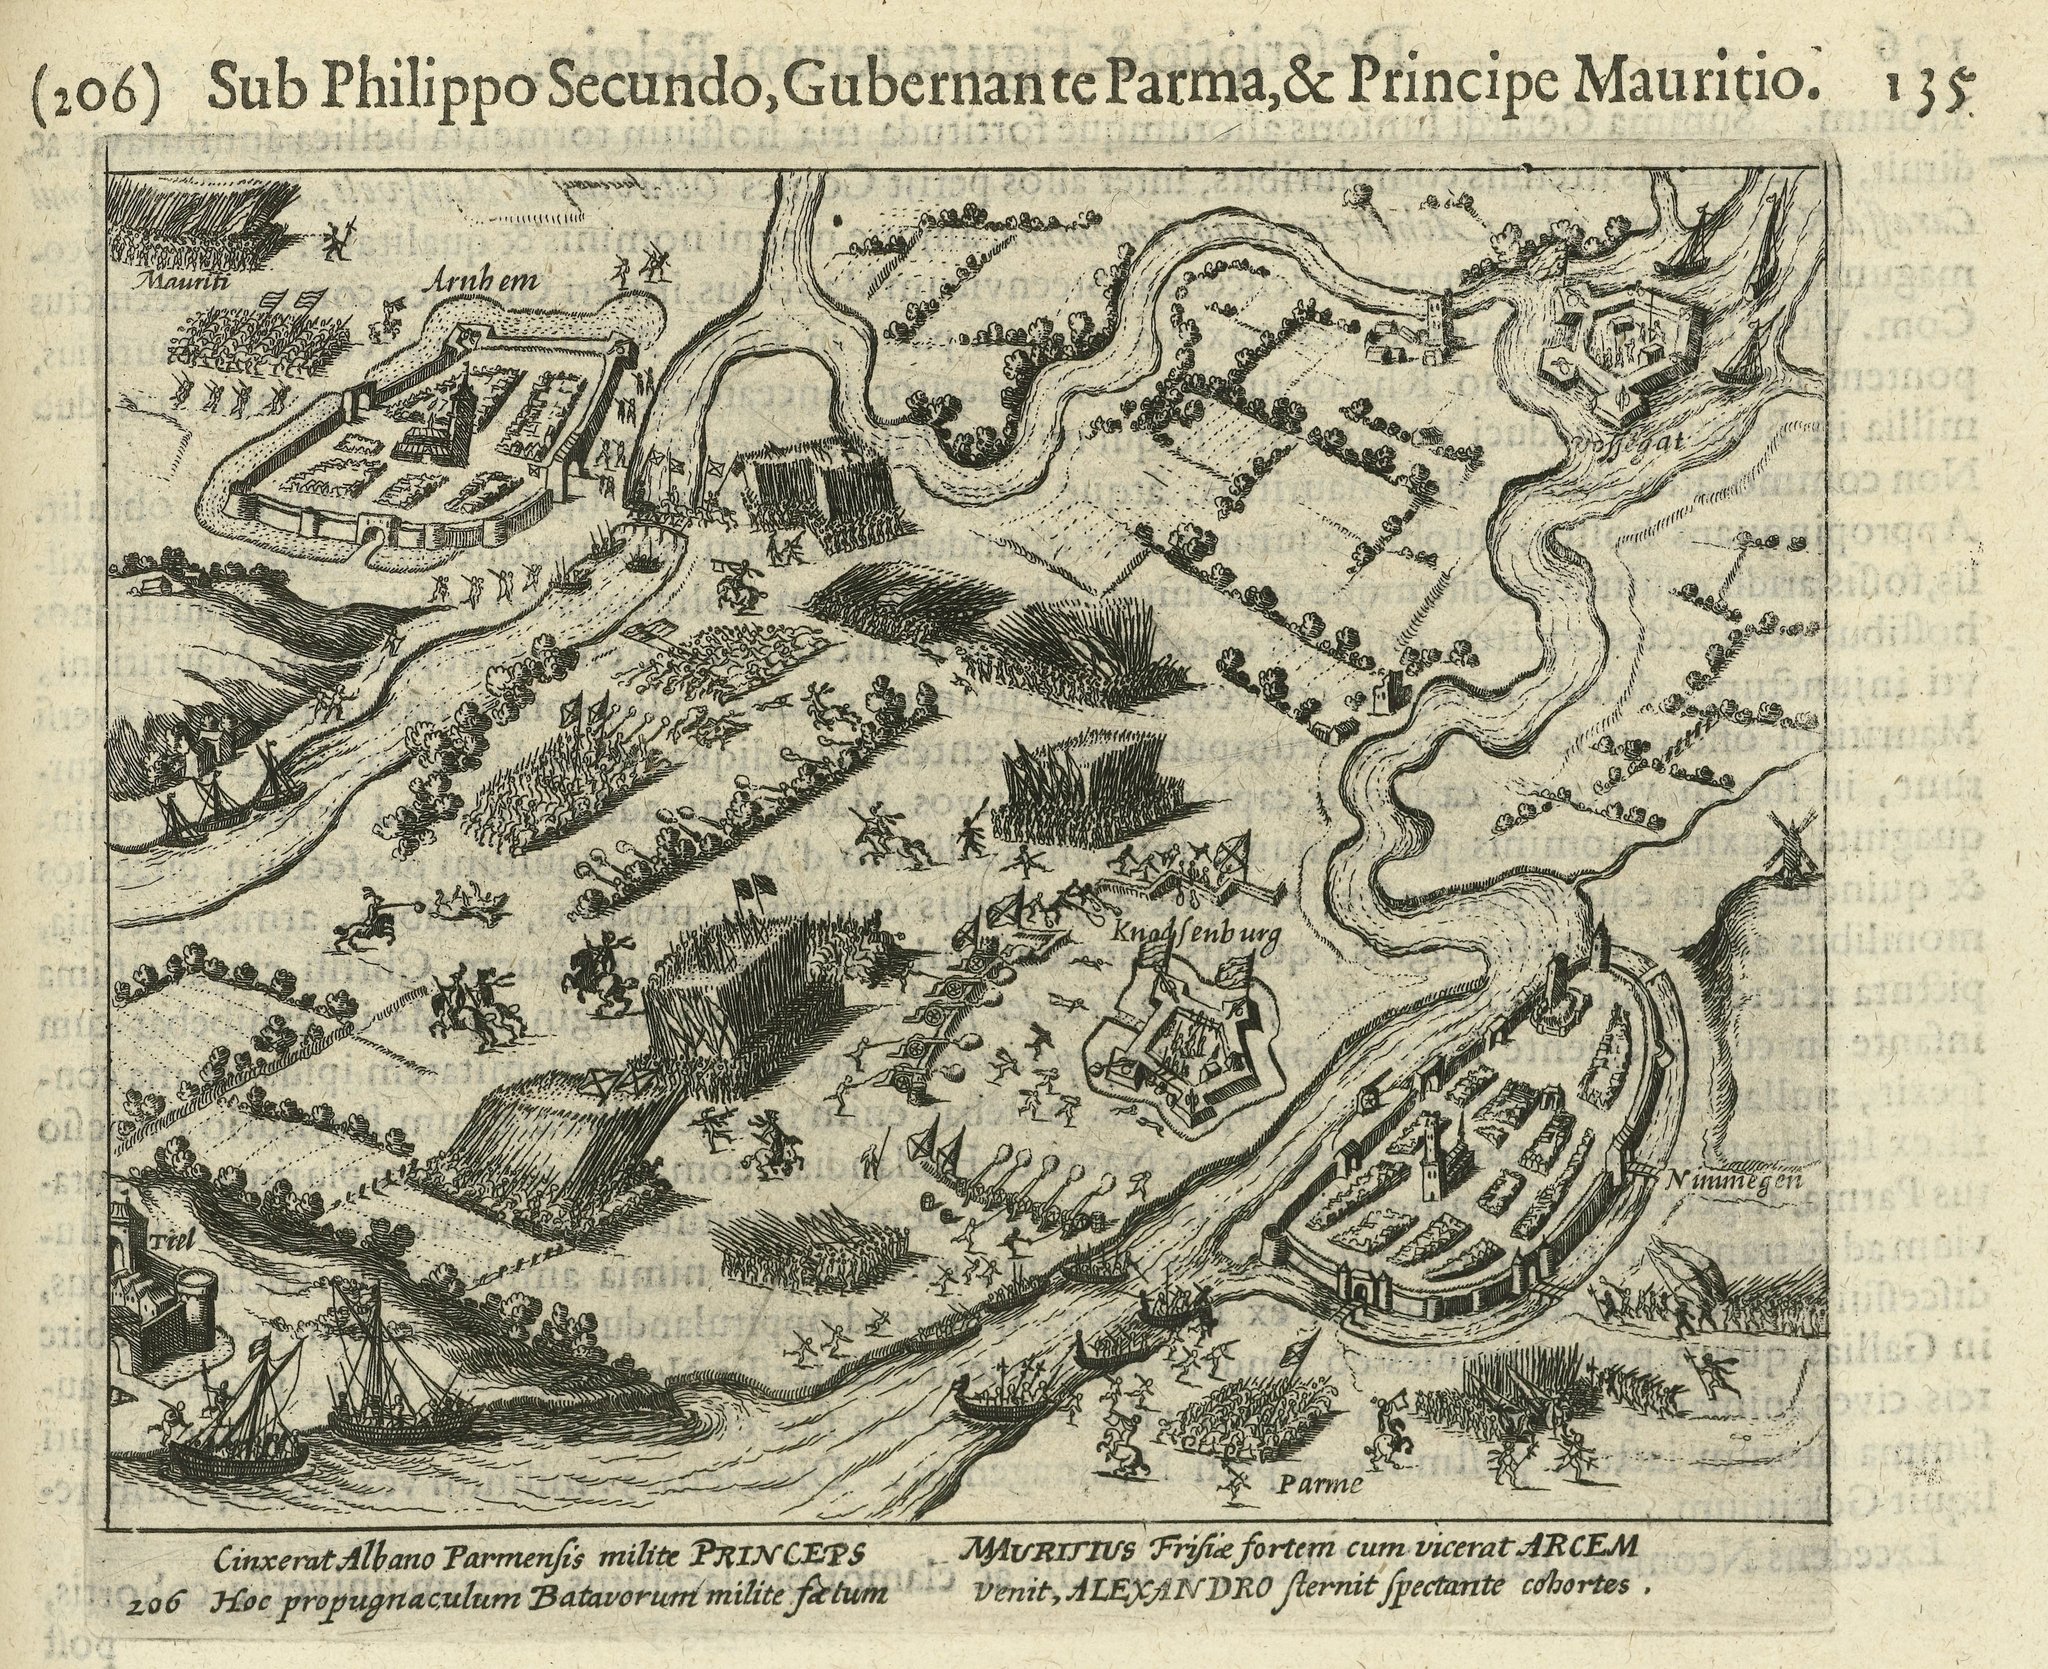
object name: print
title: Ontzet van Knodsenburg, 1591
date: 1613-1615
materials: paper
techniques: etching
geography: amsterdam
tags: raising the siege with outside assistance, relief, siege, position war, nijmegen, arnhem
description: Beleg van het fort Knodsenburg door de hertog van Parma en ontzet door het leger van prins Maurits, 25 juli 1591. De voorstelling toont het beleg van het fort, de gevechten tussen de legers en de aftocht van het Spaanse leger onder Parma. Onderaan Nijmegen, bovenaan Arnhem, met de Betuwe tussen de Rijn en de Waal. Met onderschrift van 4 regels in het Latijn. Genummerd 206. Bedrukt op achterzijde met tekst in het Latijn.